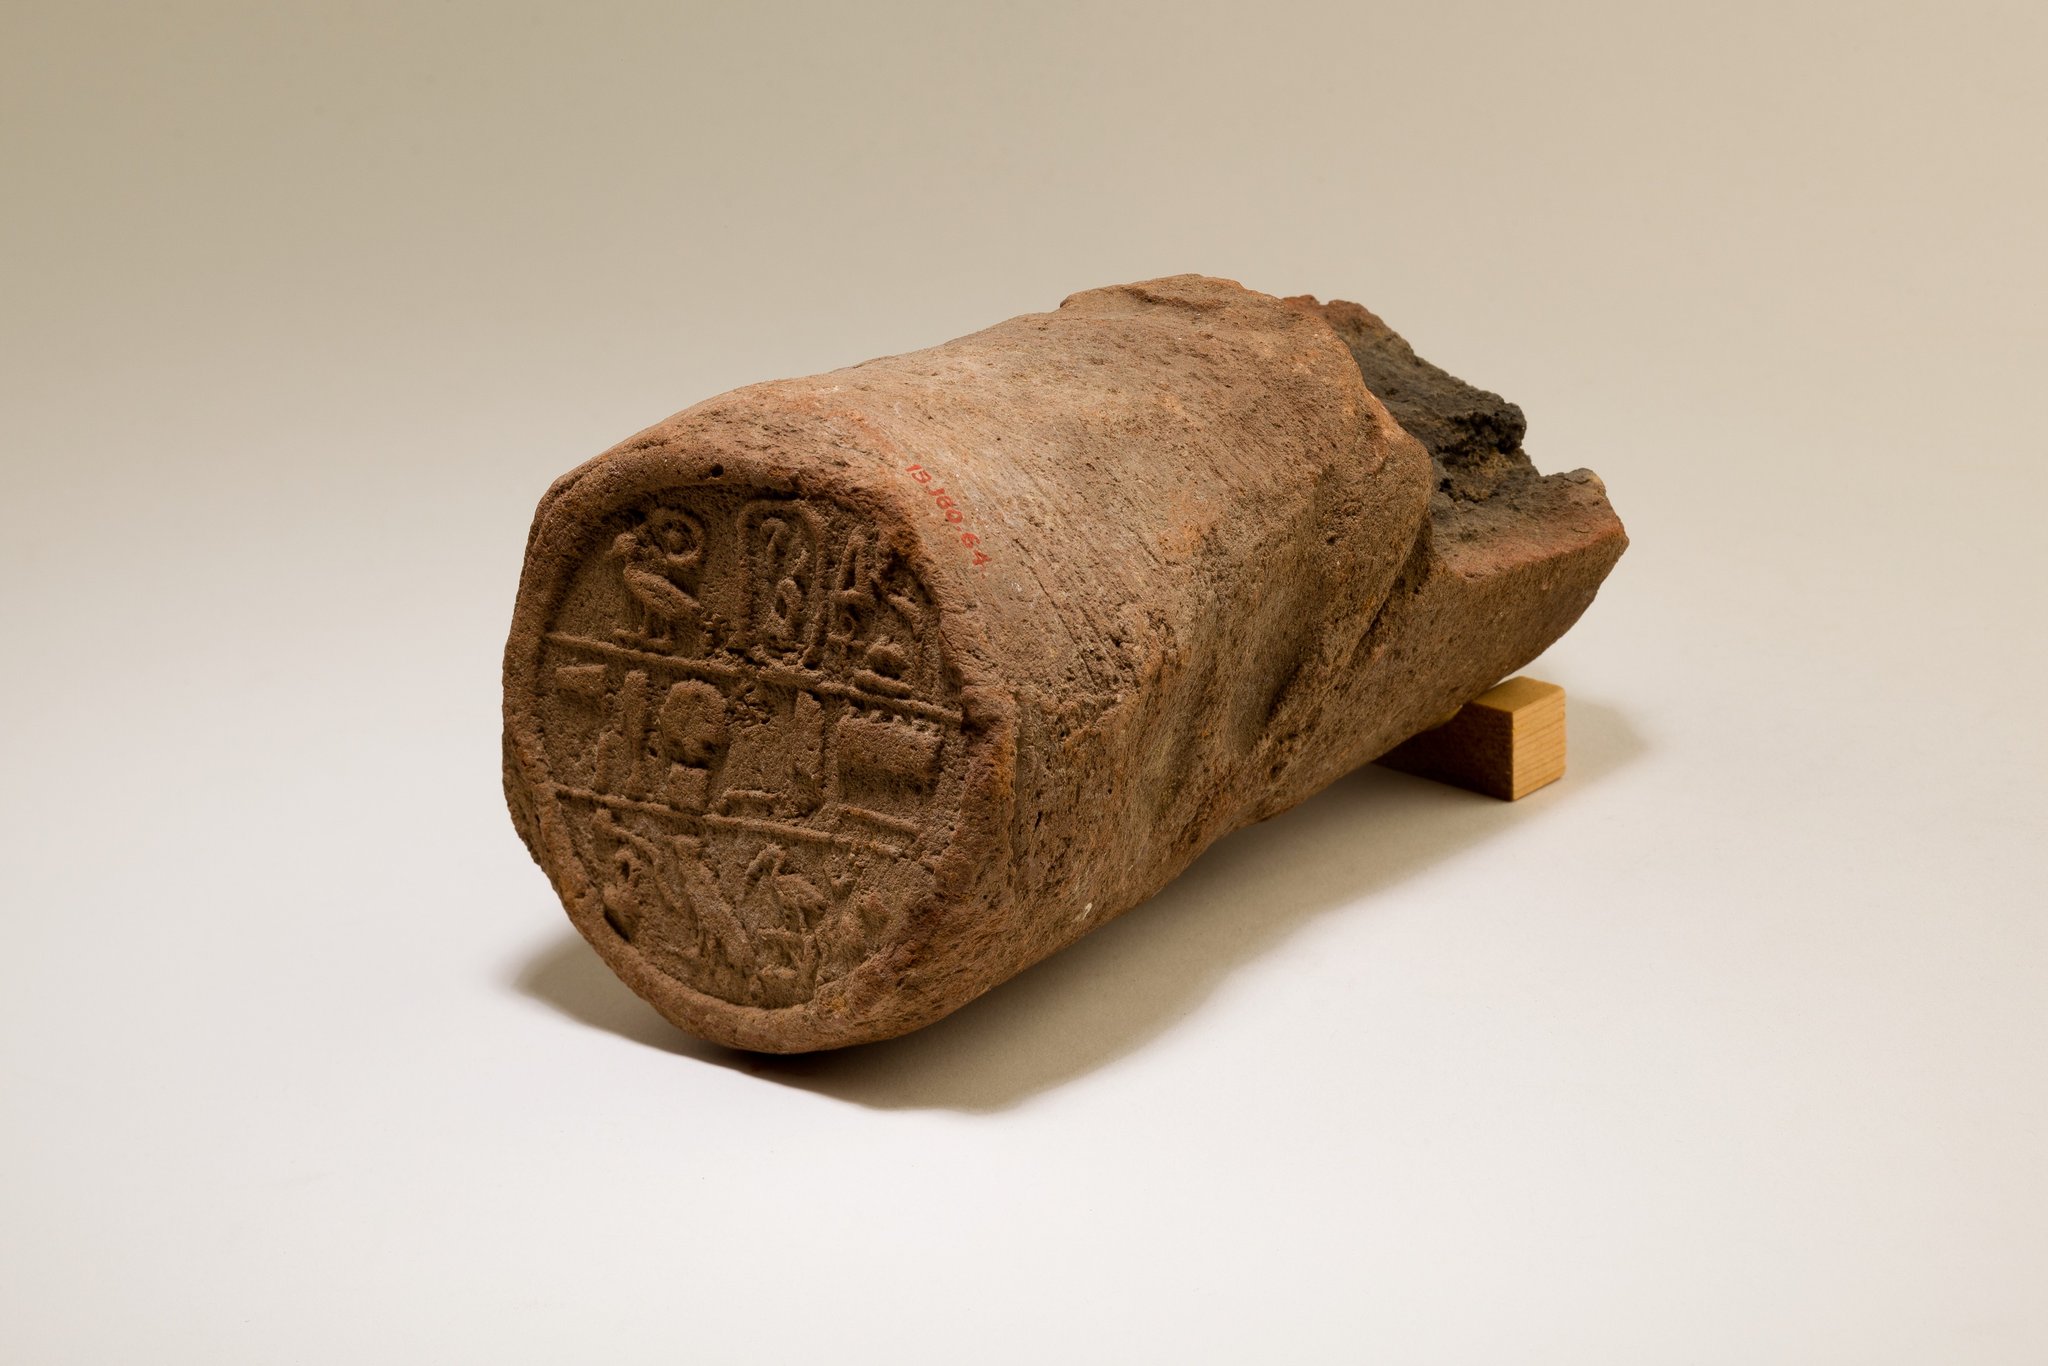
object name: cone, curcular impression, djehuty, first prophet of amun, seal bearer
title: Funerary Cone of High Priest of Amun Djehuty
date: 1550-1525 BCE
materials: pottery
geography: egypt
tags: hieroglyphs